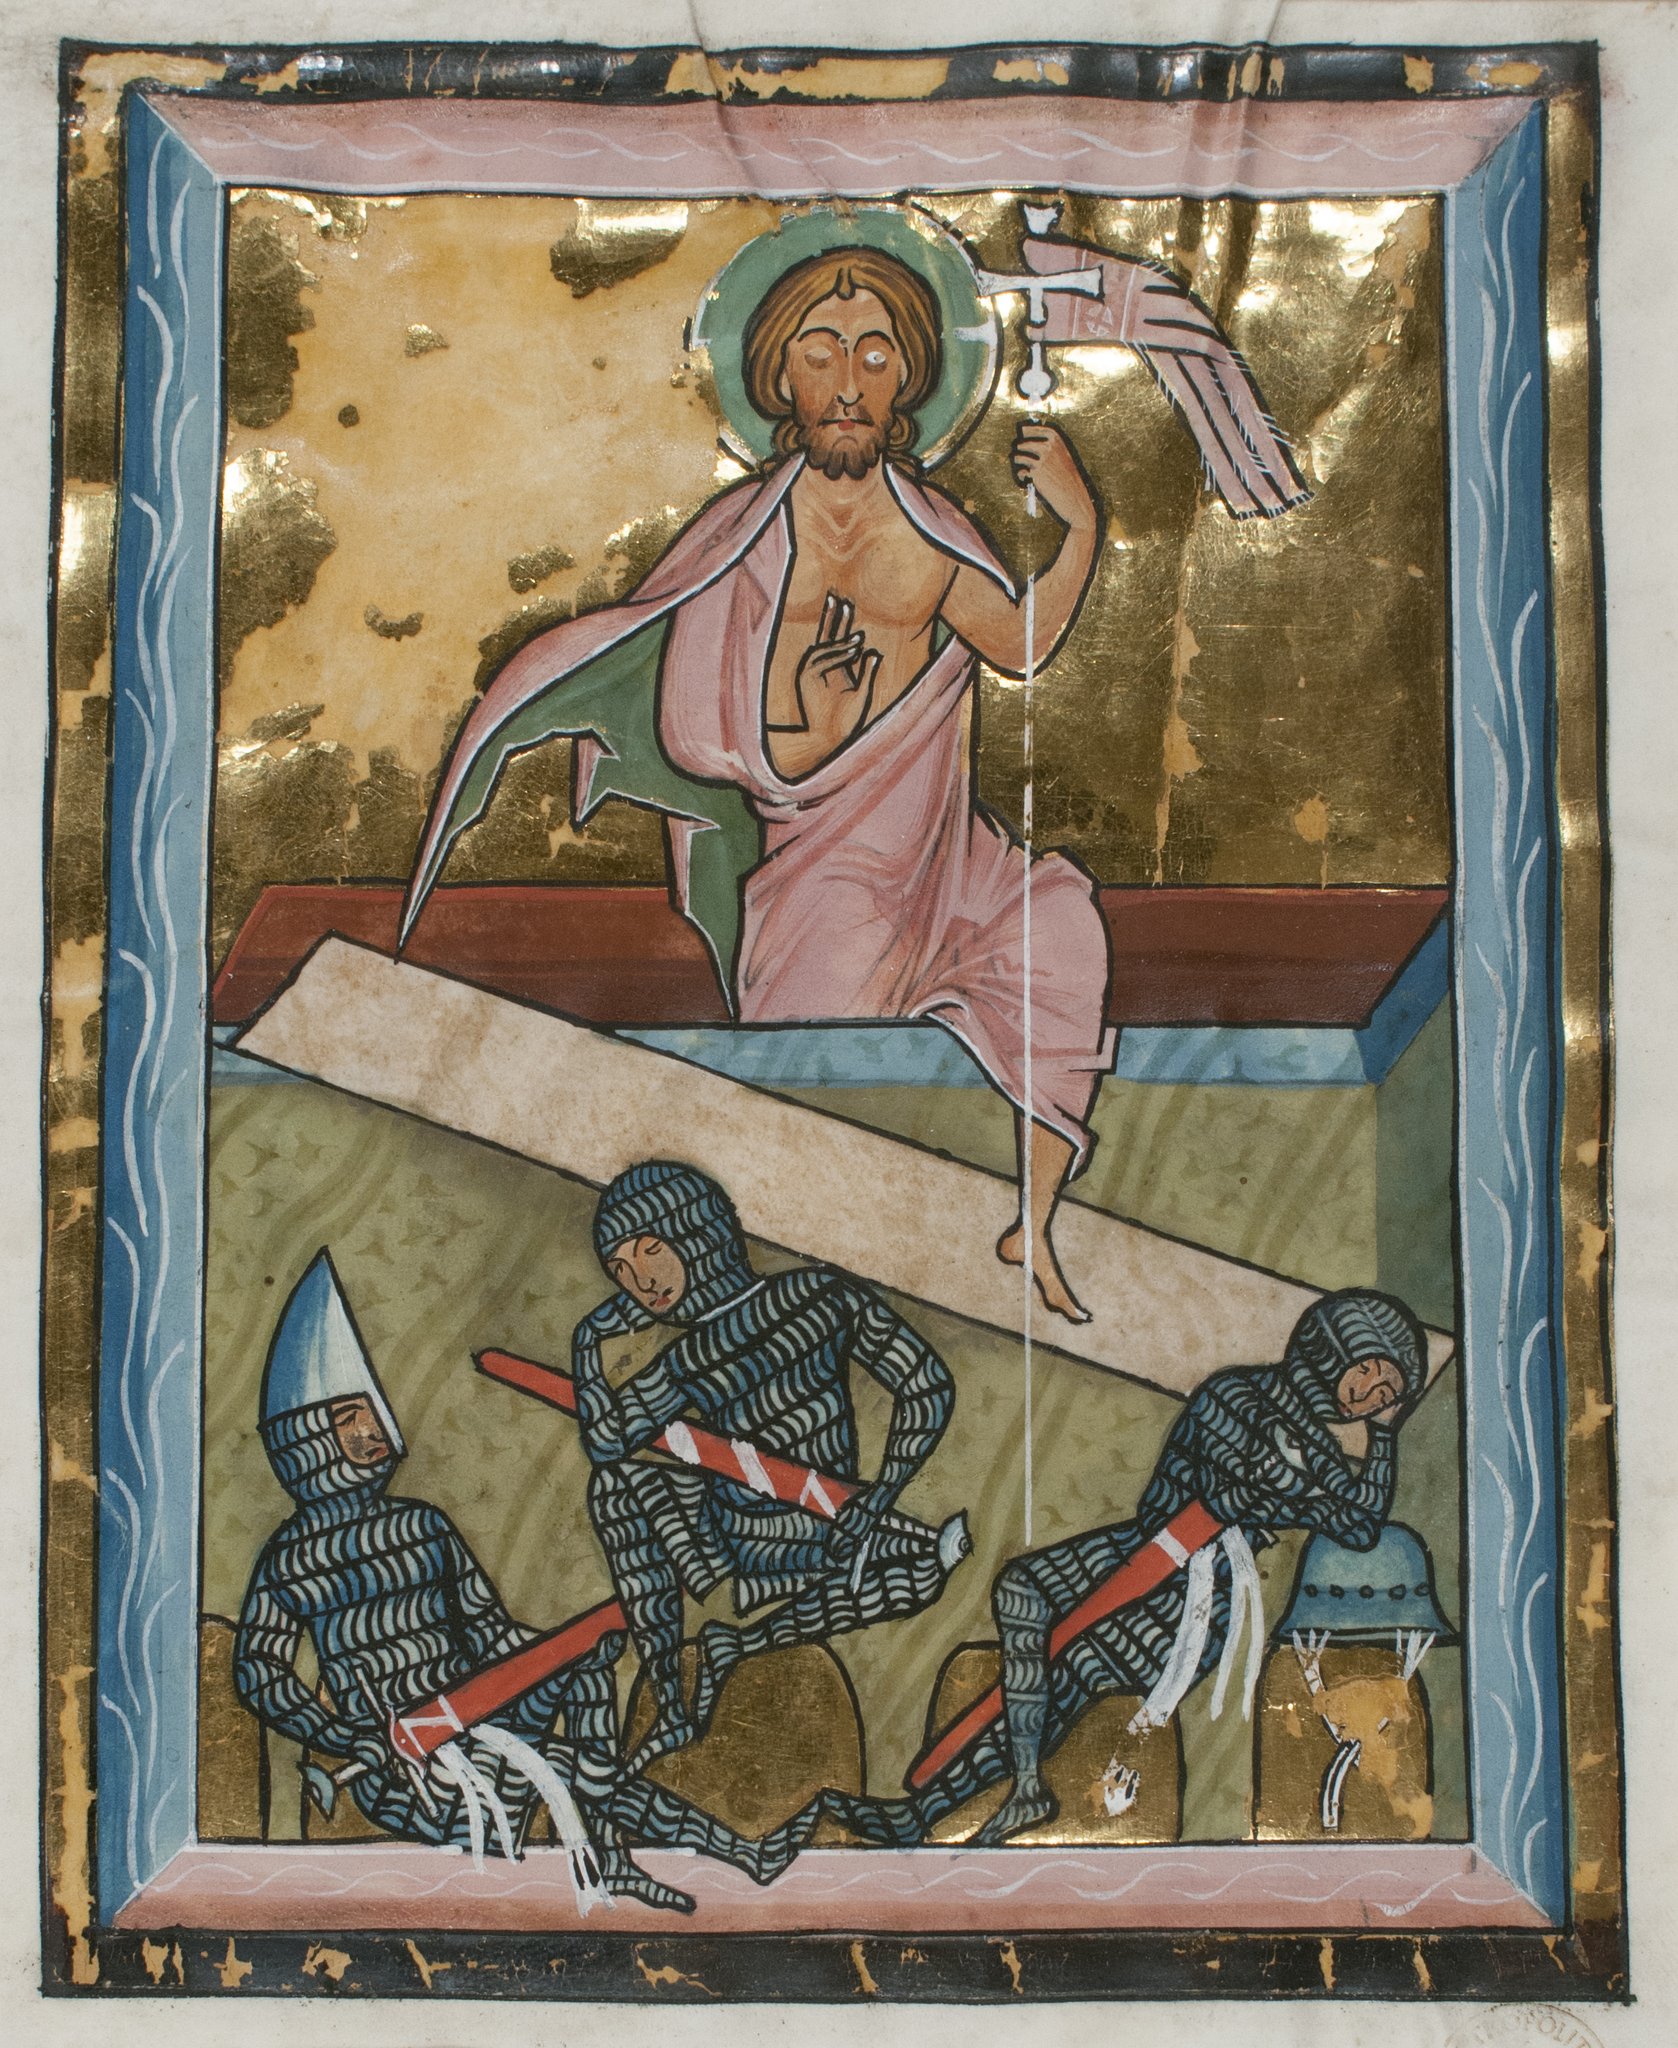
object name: psalter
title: Manuscript Leaf with the Resurrection, from a Psalter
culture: german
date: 1234-1266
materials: gold, ink, parchment, silver, paint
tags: soldiers,men,christ